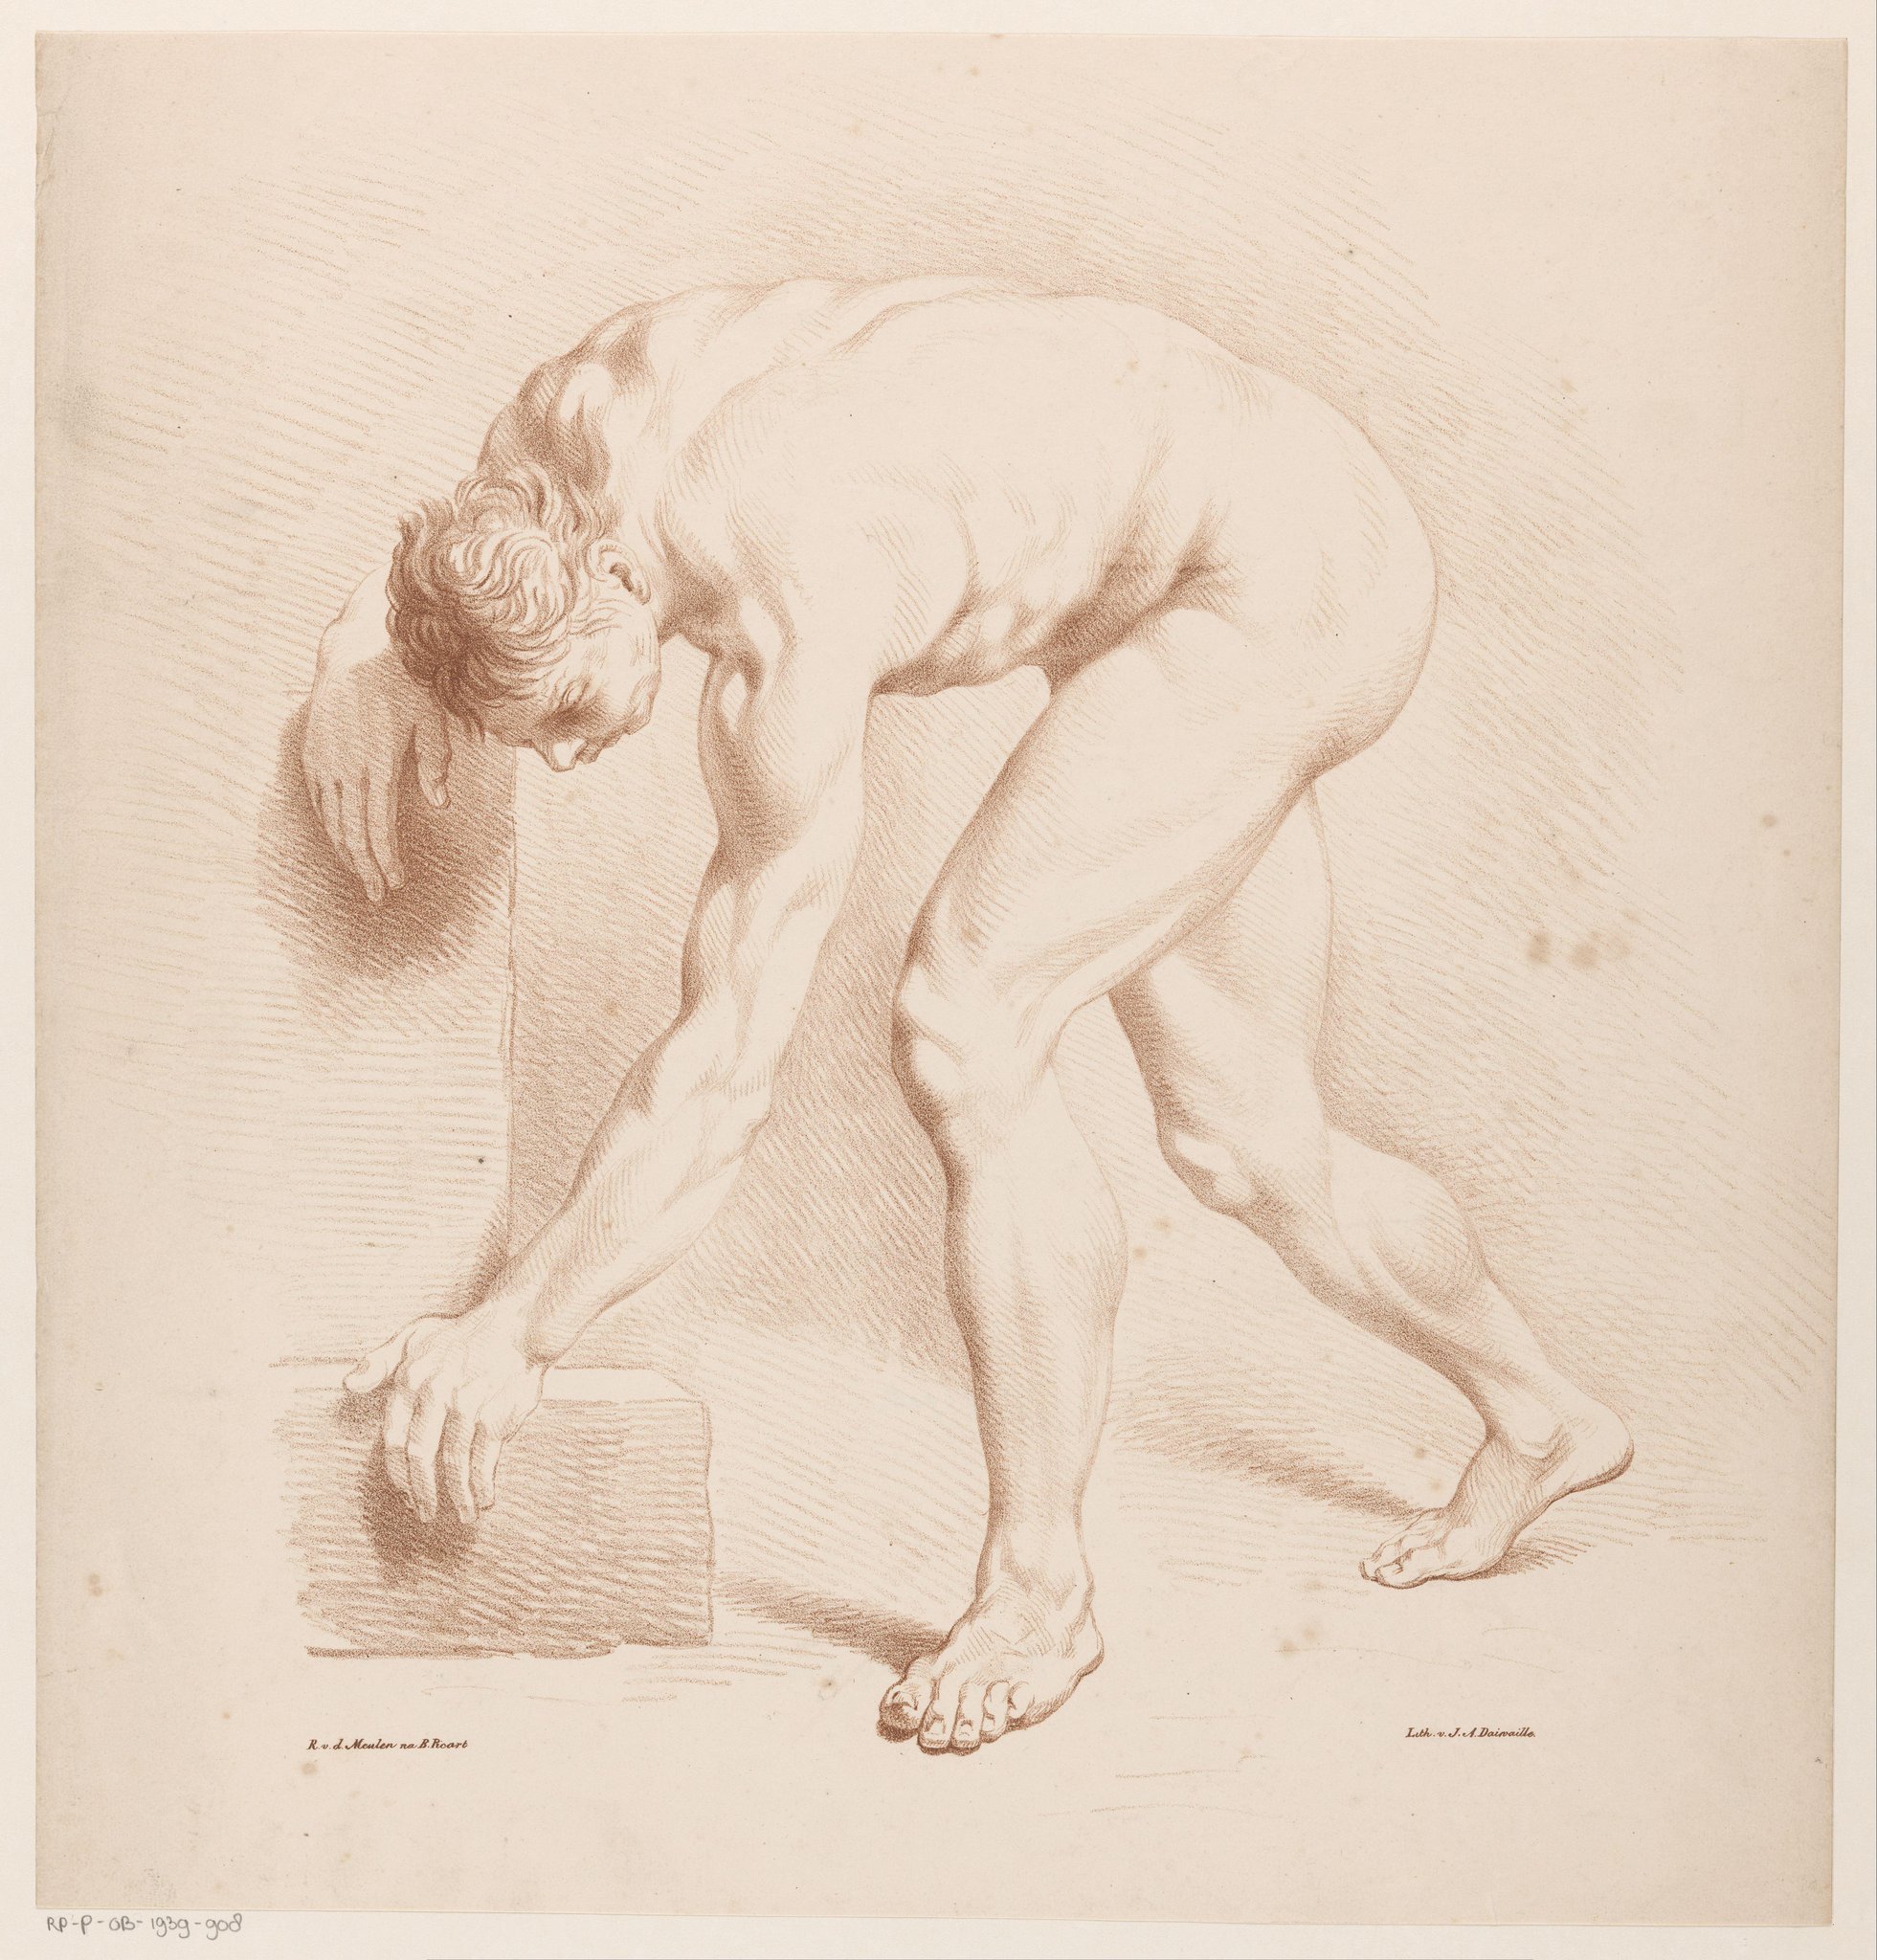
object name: print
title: Gebogen naakte man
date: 1820-1833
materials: paper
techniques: lithograph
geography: amsterdam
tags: bending figure, the (nude) human figure; 'corpo humano' (ripa)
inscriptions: collector's mark: Lugt 2760, collector's mark: 2228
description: Het rechterbeen van de man staat verder naar achteren. Met zijn rechter onderarm leunt hij op een muur of blok. Met zijn linkerhand rust hij op een lagergelegen blok.